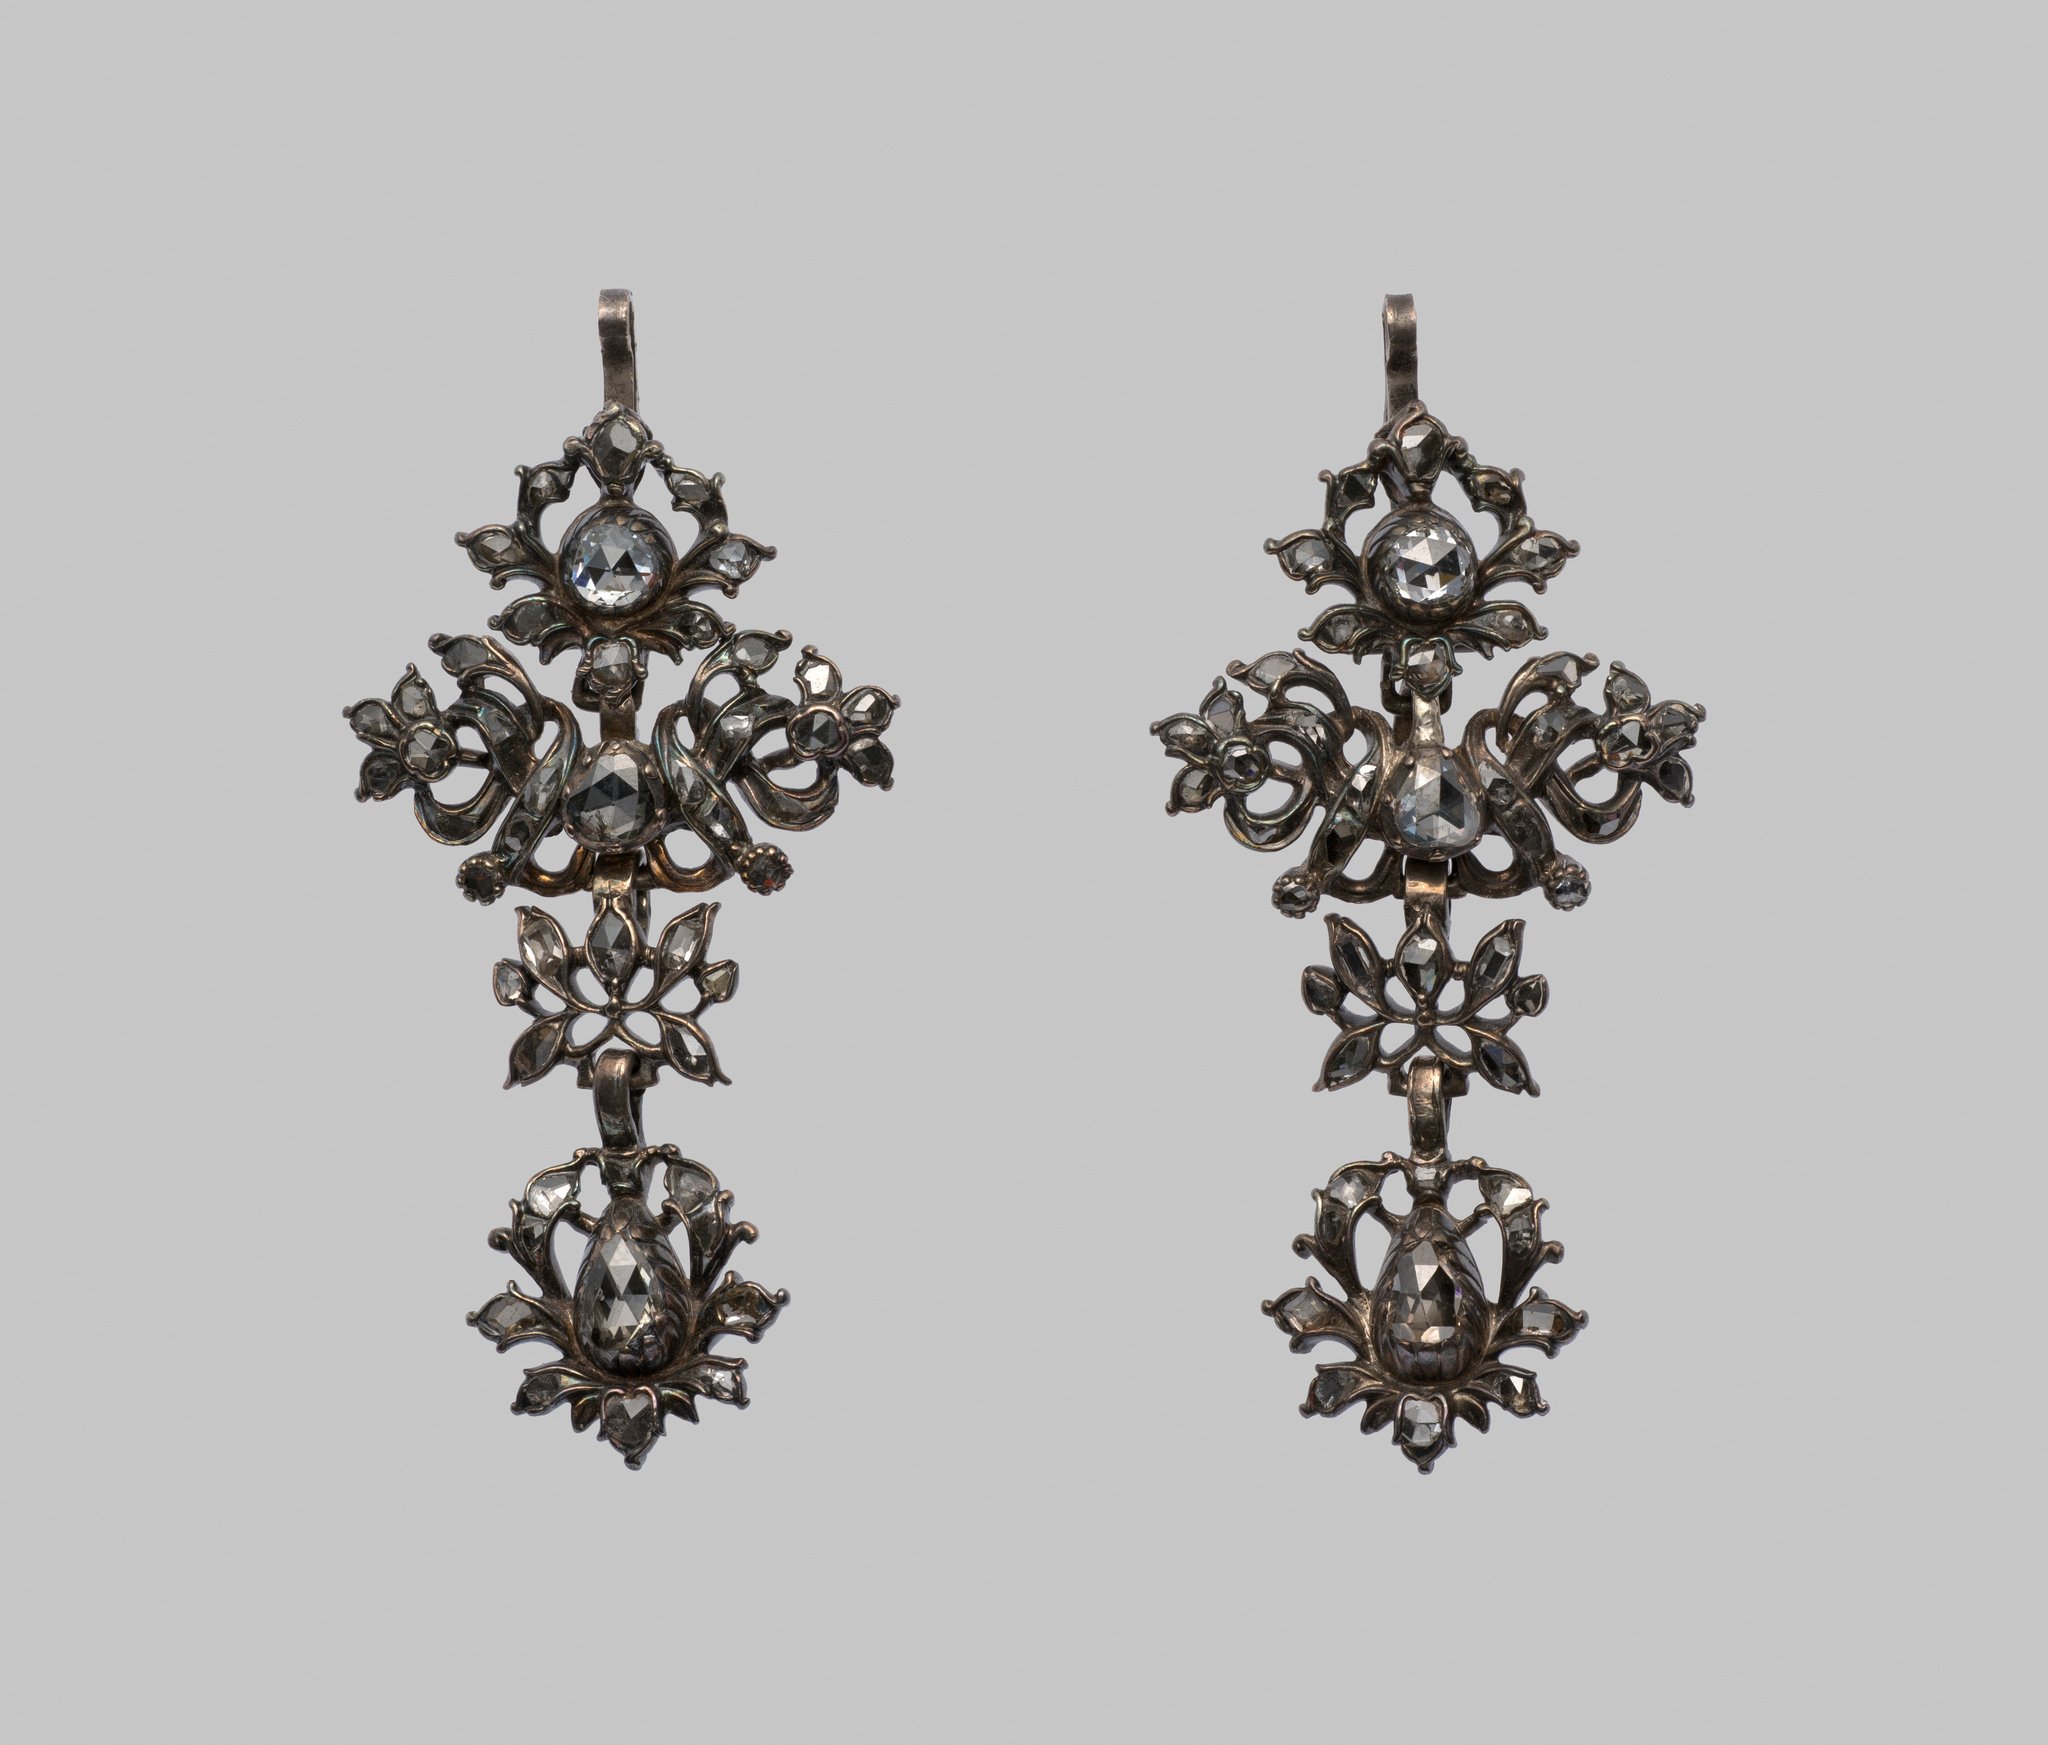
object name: earring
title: Pair of earrings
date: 1701-1733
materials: diamond, silver